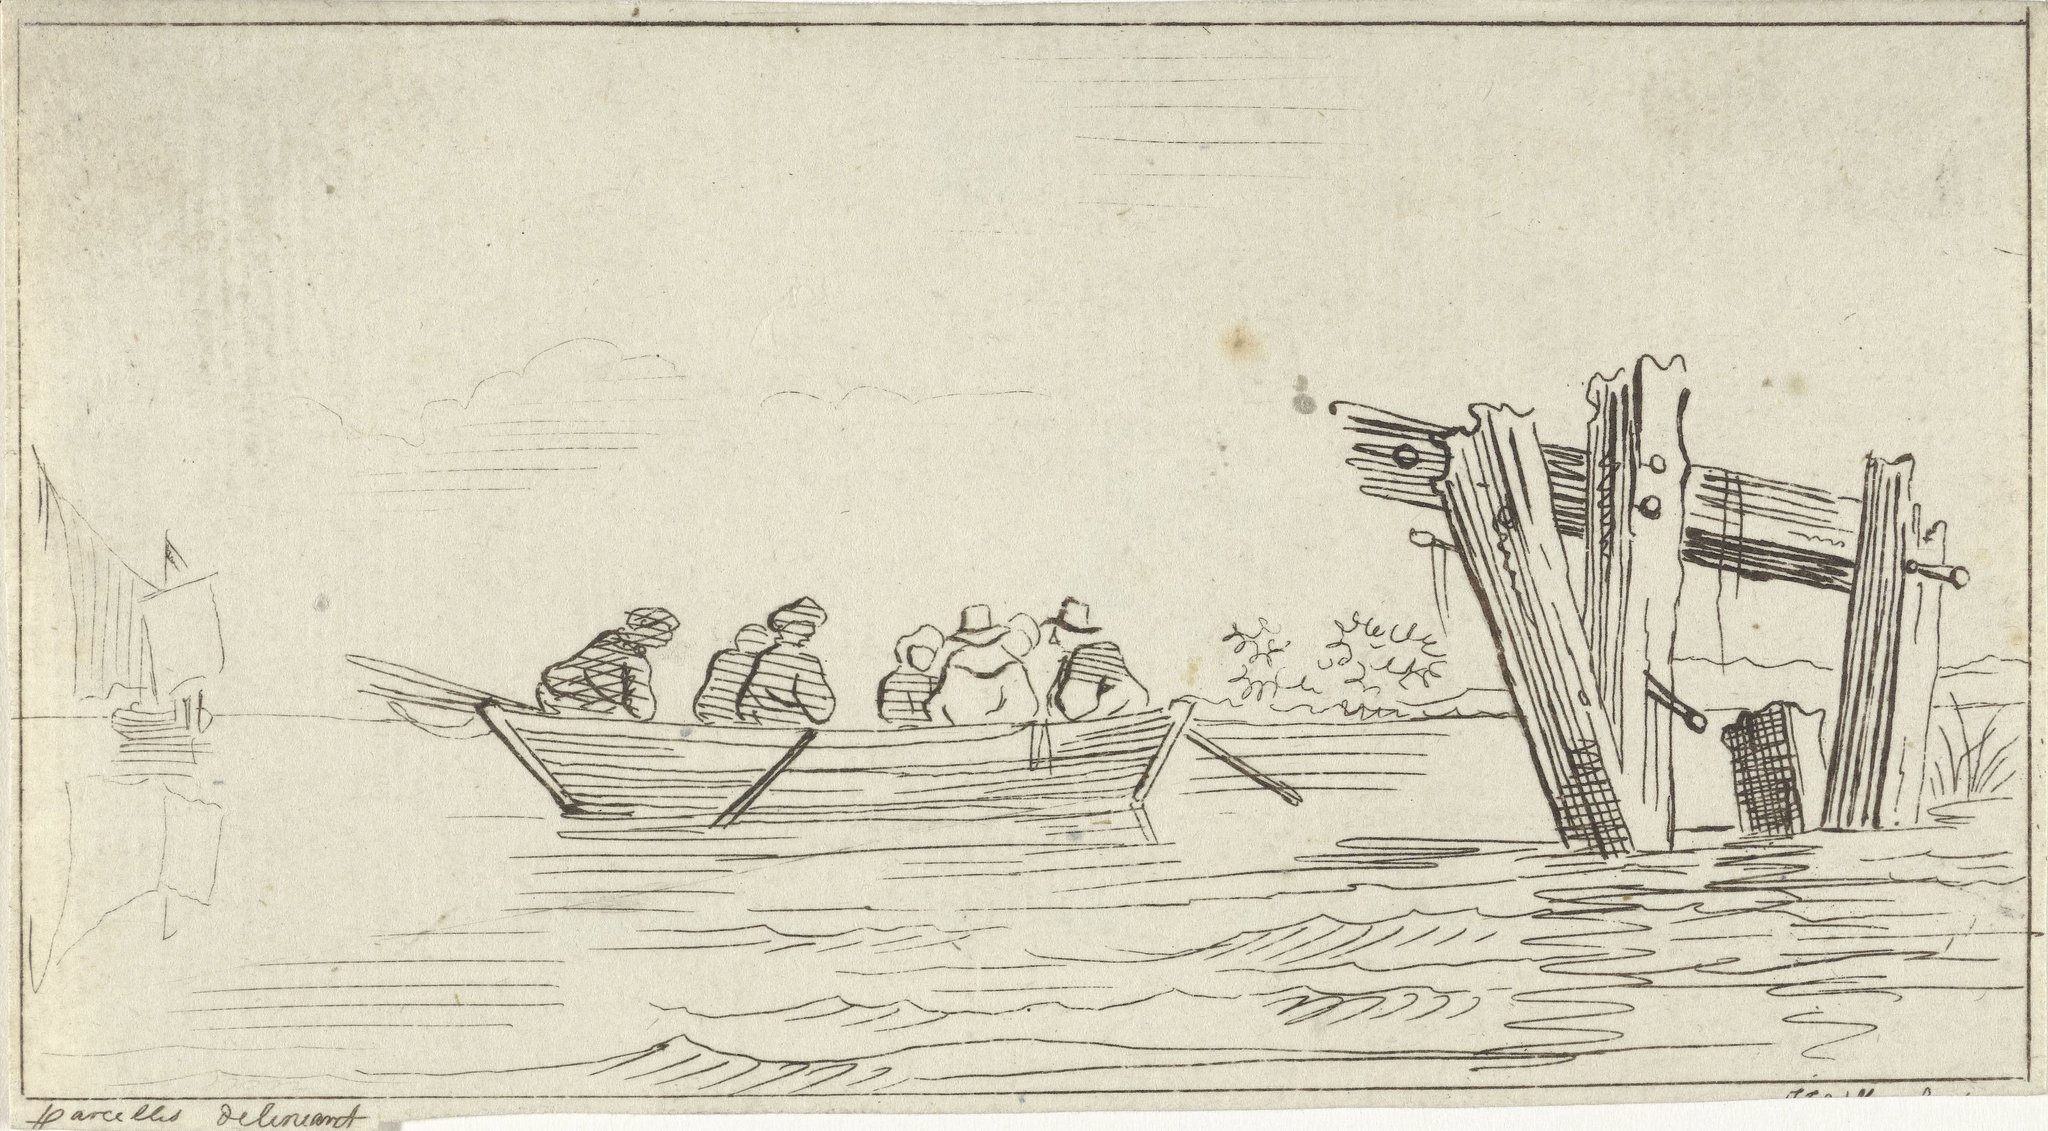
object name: print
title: Roeiboot met figuren op een rivier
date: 1771-1802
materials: paper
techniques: etching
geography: netherlands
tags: rowing-boat, canoe, etc. (+ four persons or more ~ traffic and transport)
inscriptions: collector's mark: Lugt 2228